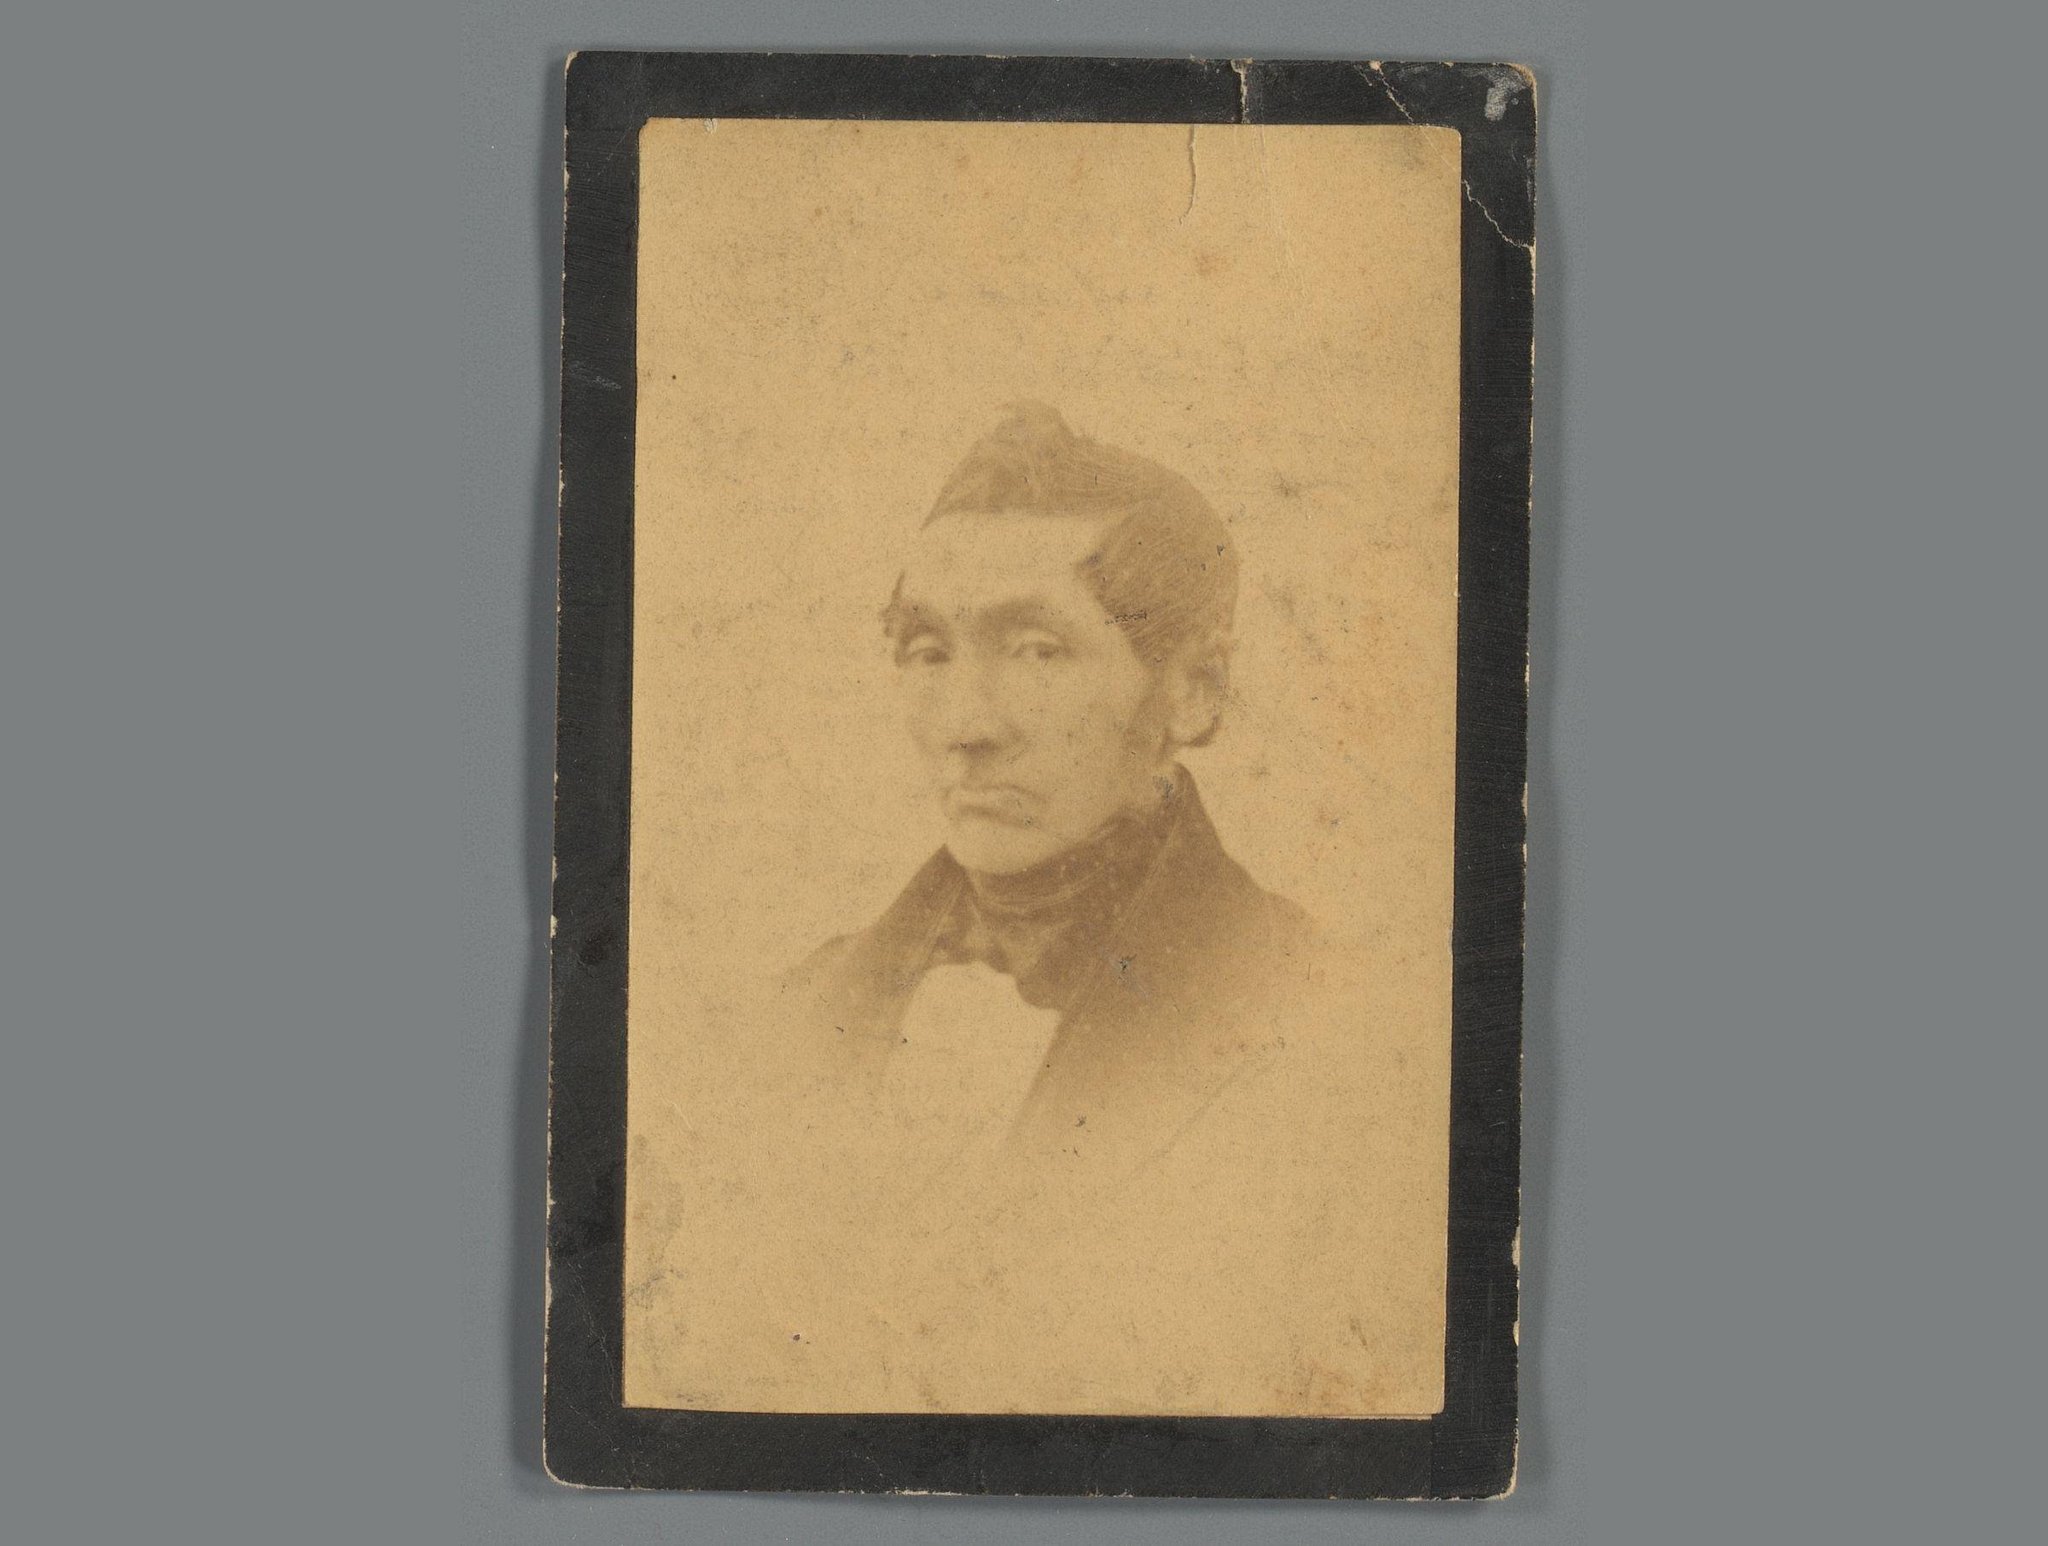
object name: prayer card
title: Portret van Joannes Gerardus Josephus Bertels op bidprent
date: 1870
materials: paper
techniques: albumen print, letterpress printing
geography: krommenie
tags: adult man, historical persons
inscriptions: inscription: ‘Bid voor de Ziel/ van zaliger (...) R.I.P./ te Krommenie, bij K. Veenboer.’